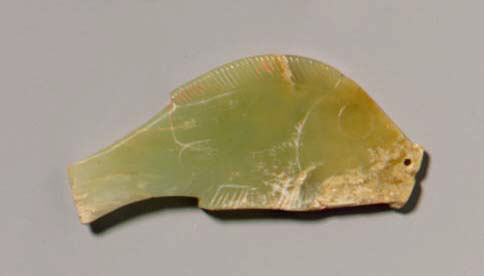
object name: plaque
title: Plaque in the Shape of a Fish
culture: chinese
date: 1200-1001 BCE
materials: jade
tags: fish